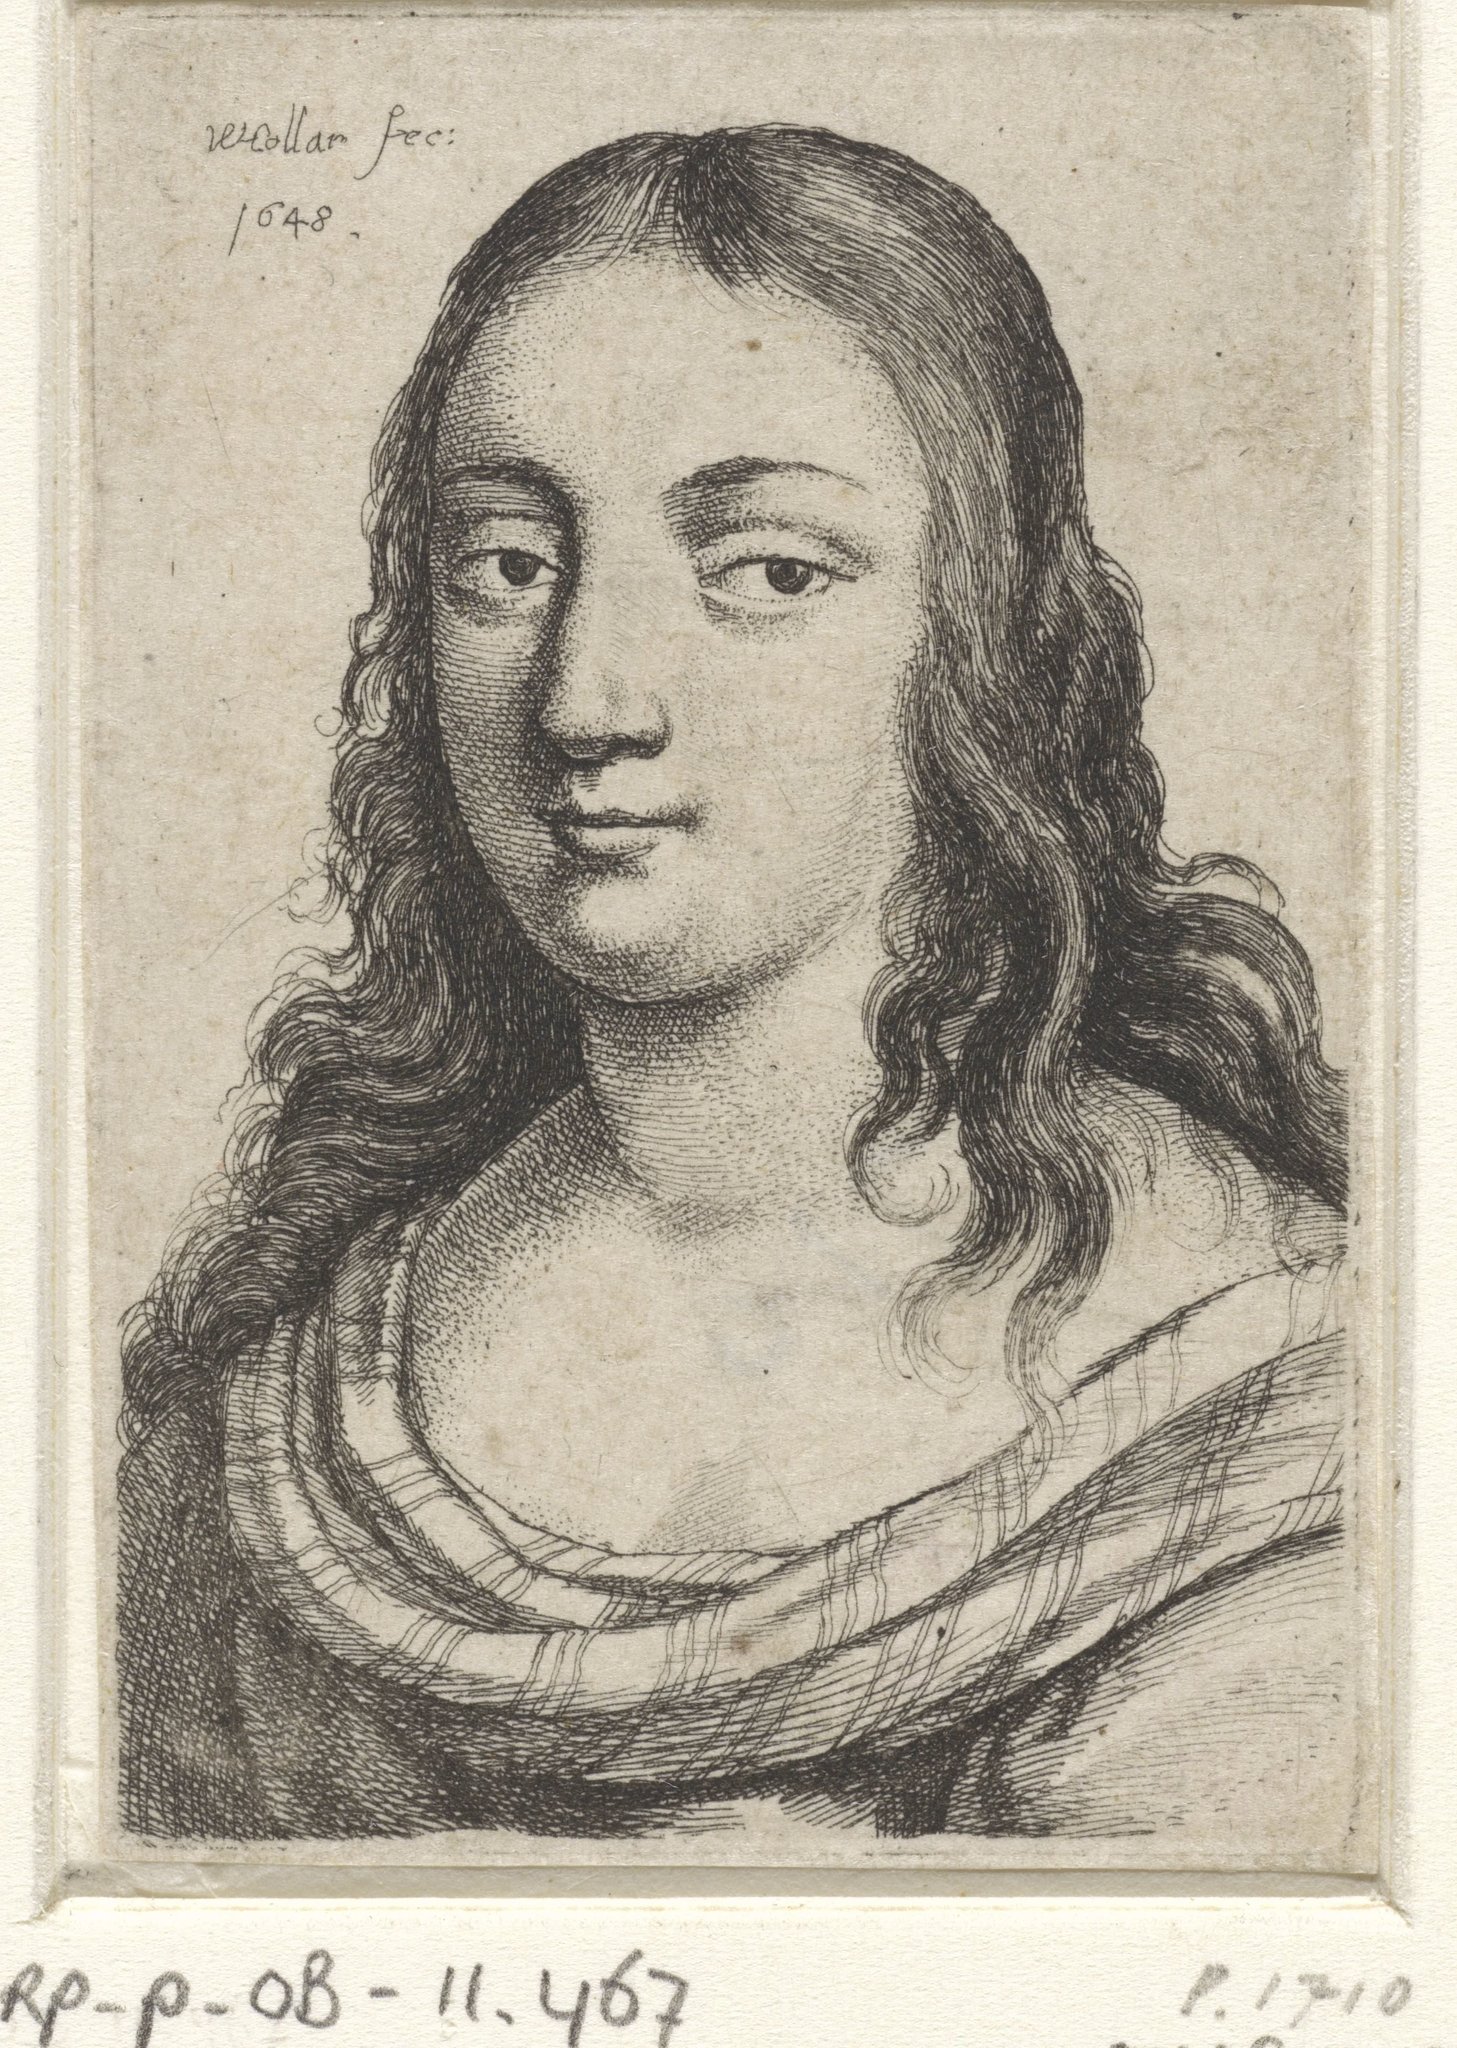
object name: print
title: Portret van een vrouw met gestreepte sjaal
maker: wenceslaus hollar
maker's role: draughtsman, print maker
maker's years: 1607-1677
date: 1648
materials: paper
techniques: etching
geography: antwerp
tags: anonymous historical person portrayed alone - bb - woman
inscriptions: collector's mark: Lugt 240